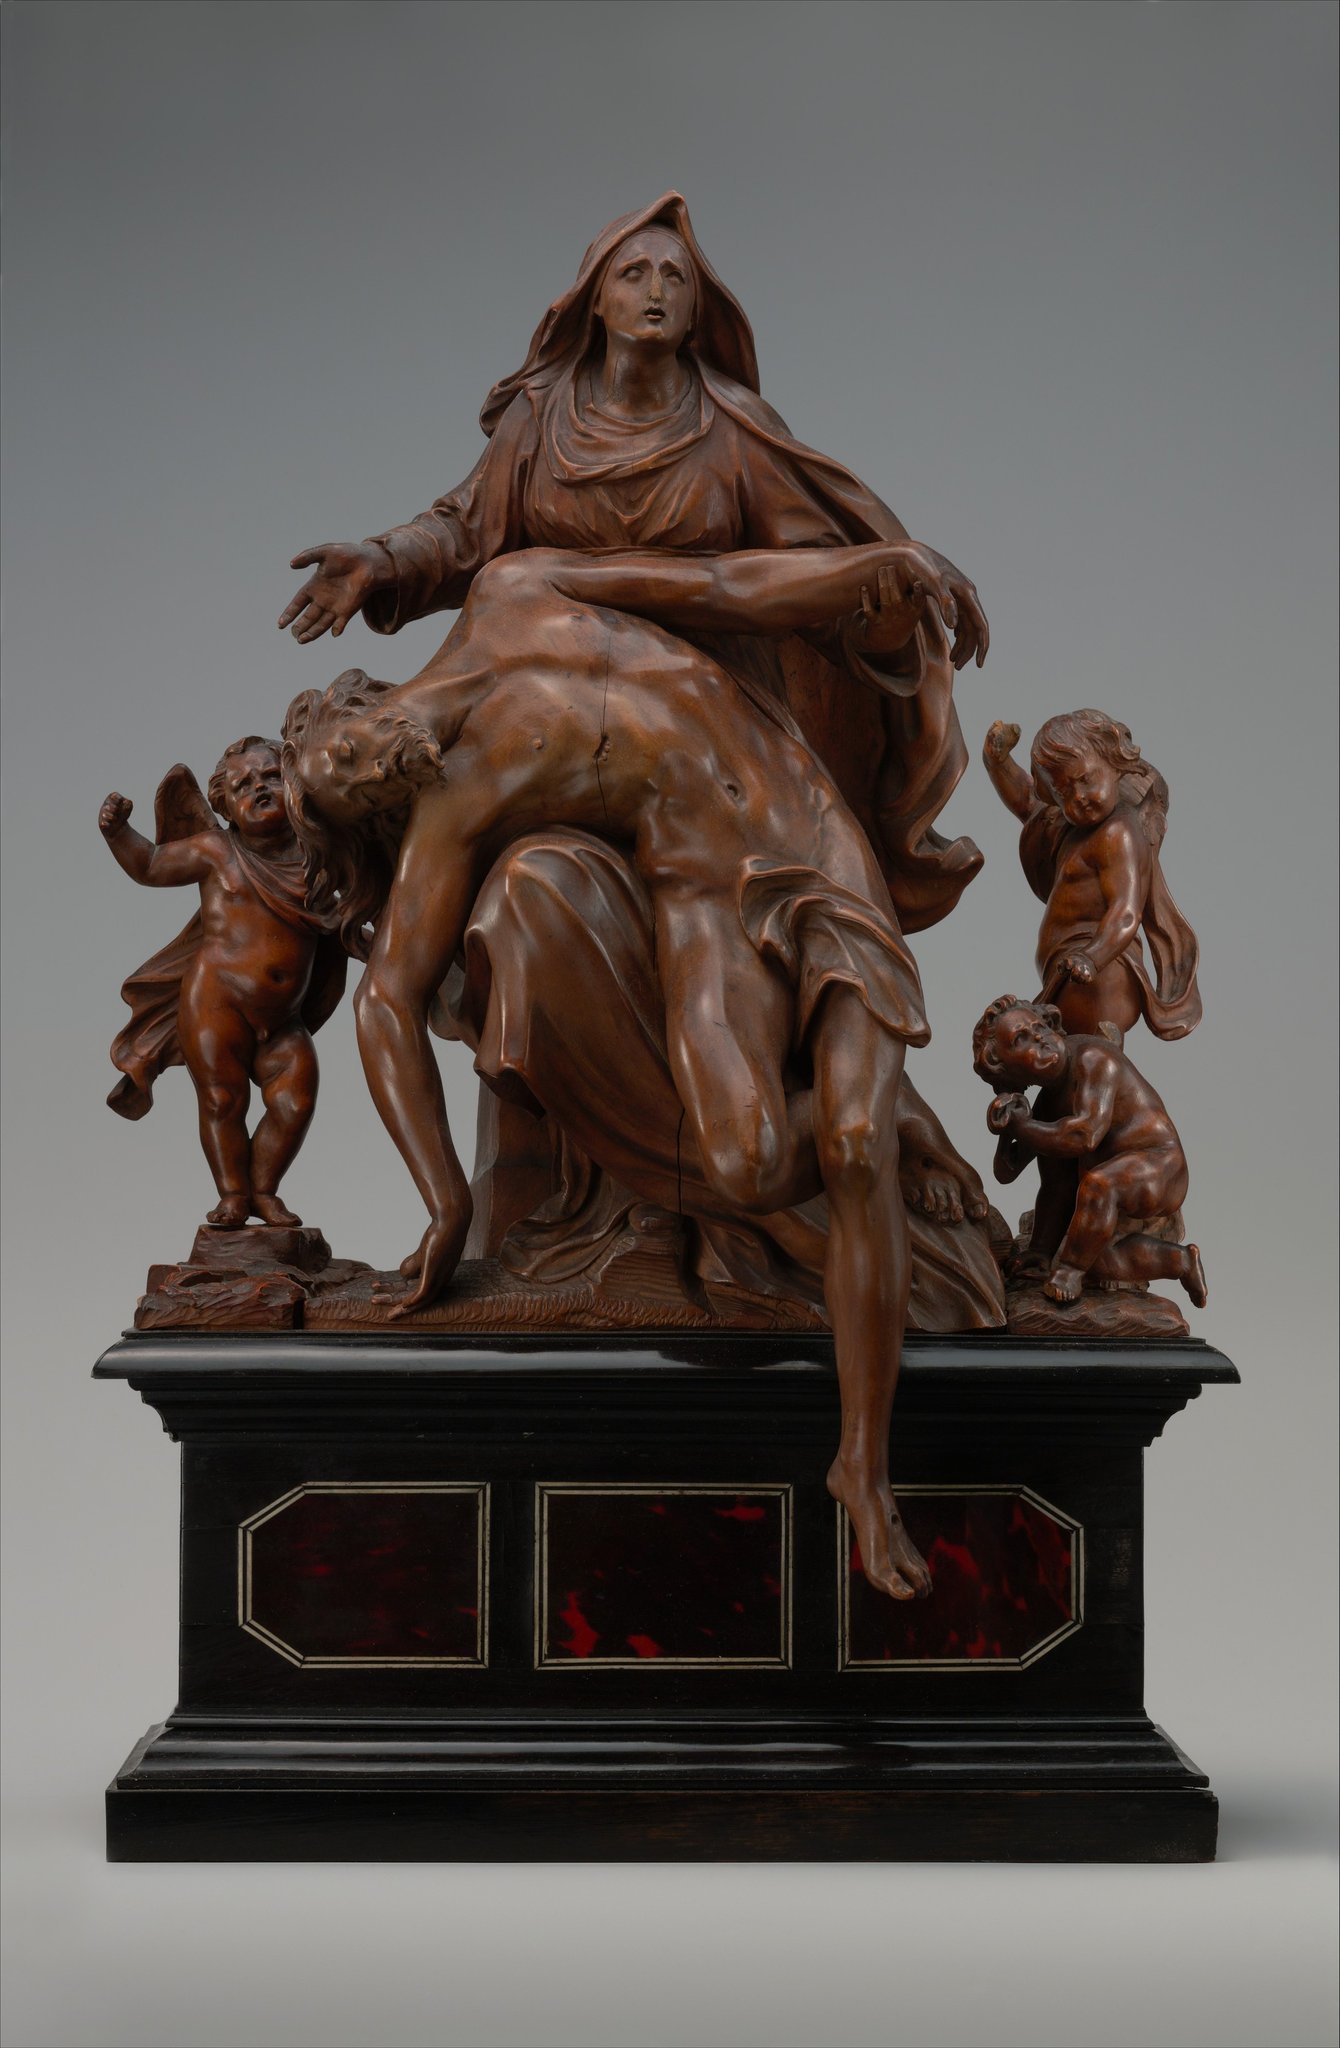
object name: statuette group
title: Pietà with Sorrowing Angels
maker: mattheus van beveren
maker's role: artist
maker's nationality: flemish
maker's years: 1630-1690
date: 1601-1700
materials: bone, wood, ivory, shell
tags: sadness,angels,virgin mary,jesus,lamentation